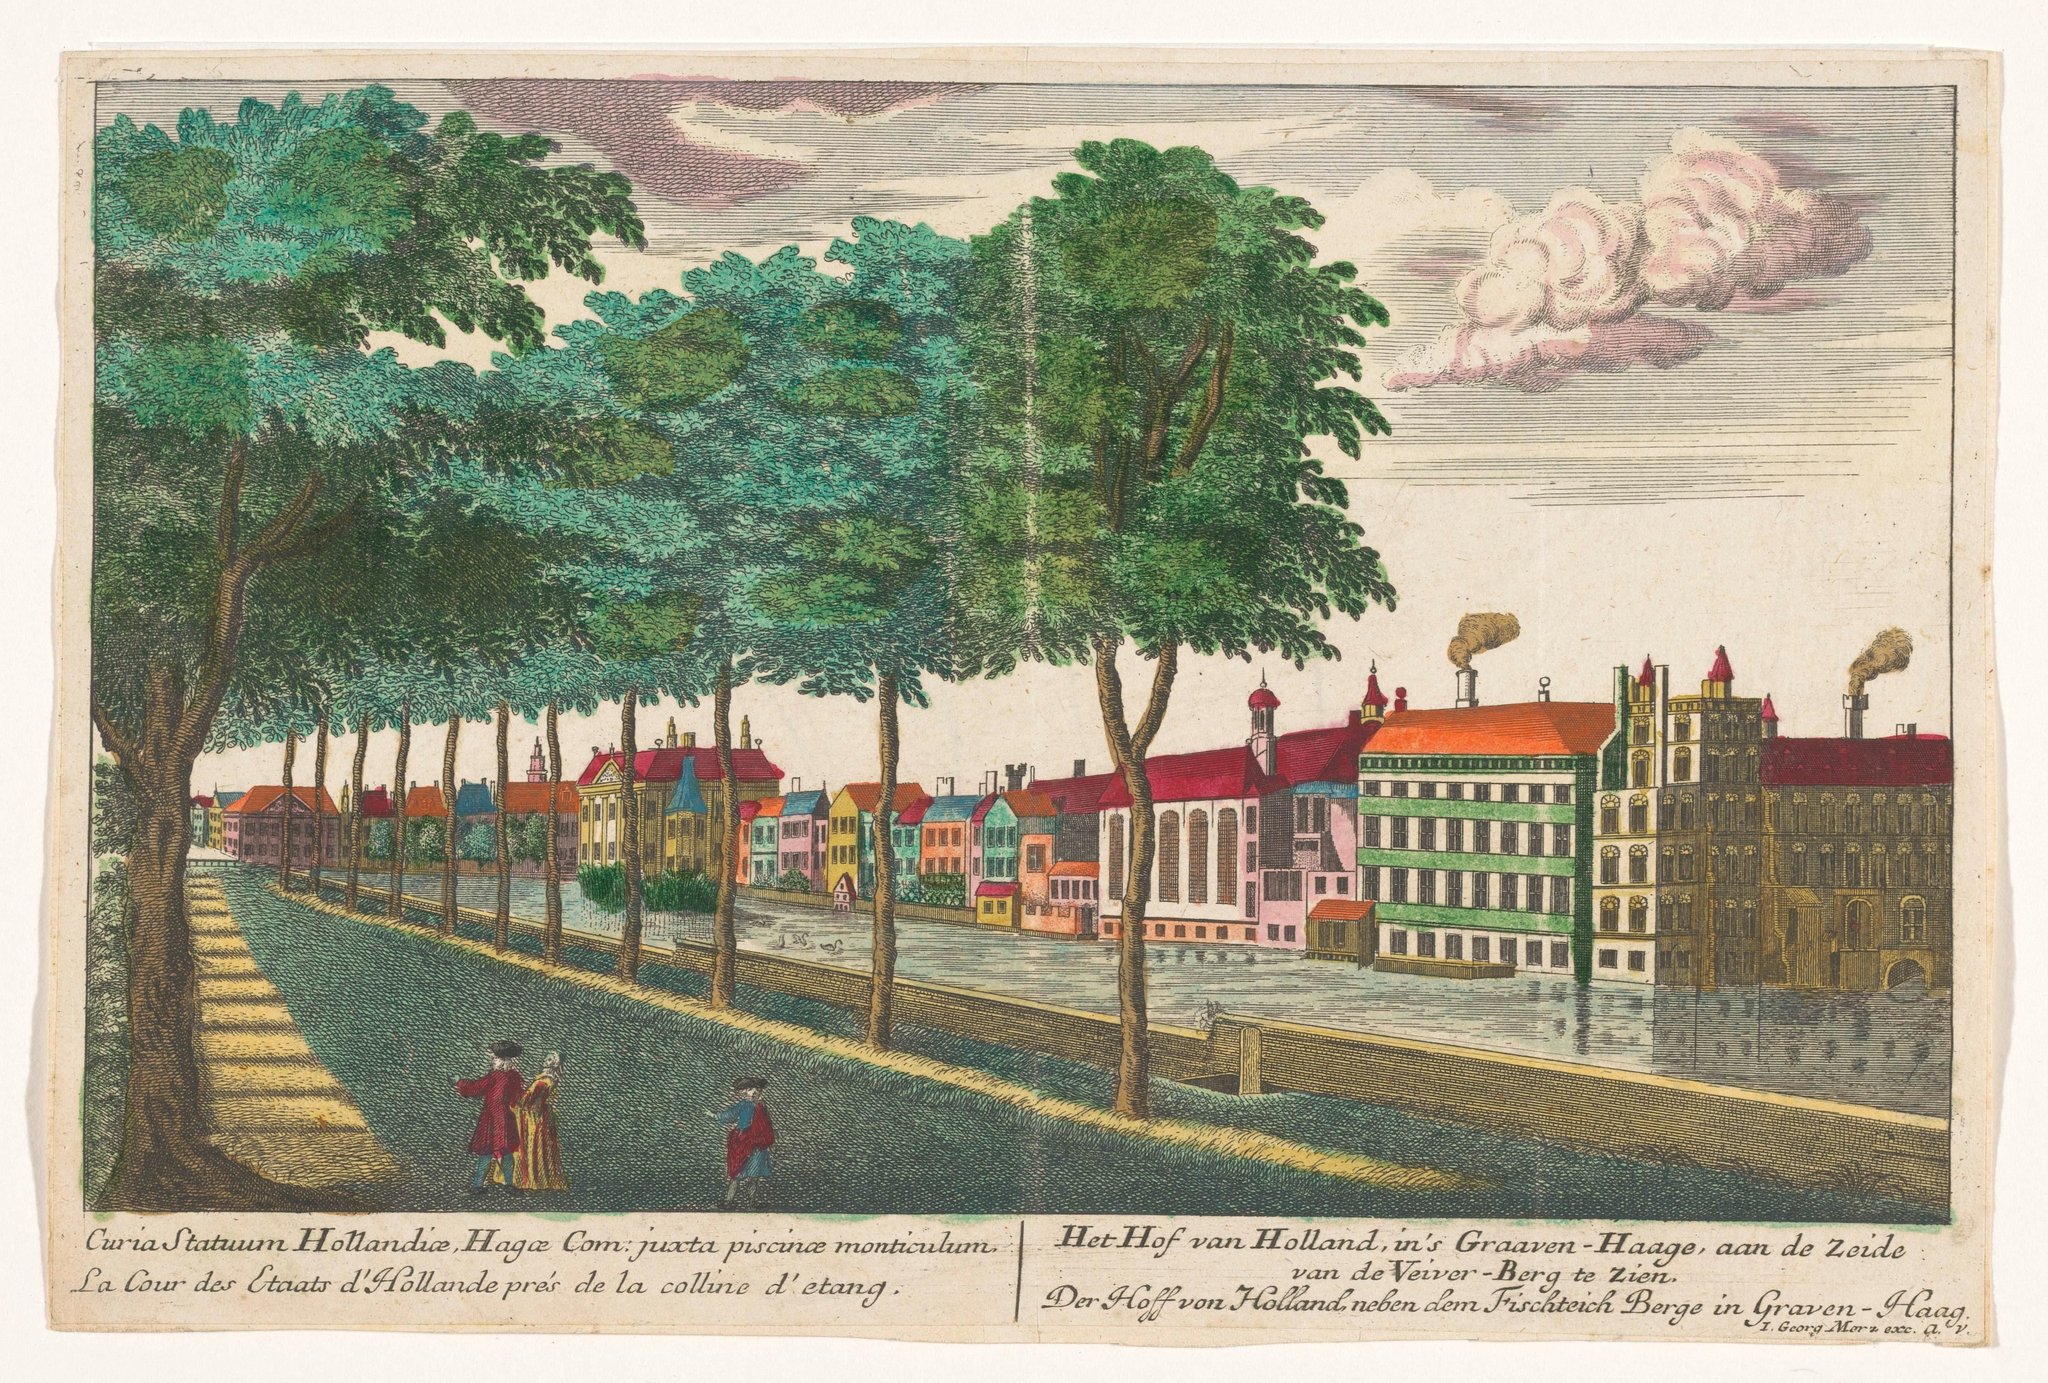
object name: print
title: Gezicht op de Hofvijver te Den Haag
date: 1704-1762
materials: paper, watercolor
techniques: brush, etching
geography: germany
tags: parts of church exterior and annexes: chapel, canals, waters (in city) (+ city(-scape) with figures, staffage), street (+ city(-scape) with figures, staffage)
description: Op de voorgrond de Vijverberg. Links het Mauritshuis. In het midden het Binnenhof met de Hofkapel.